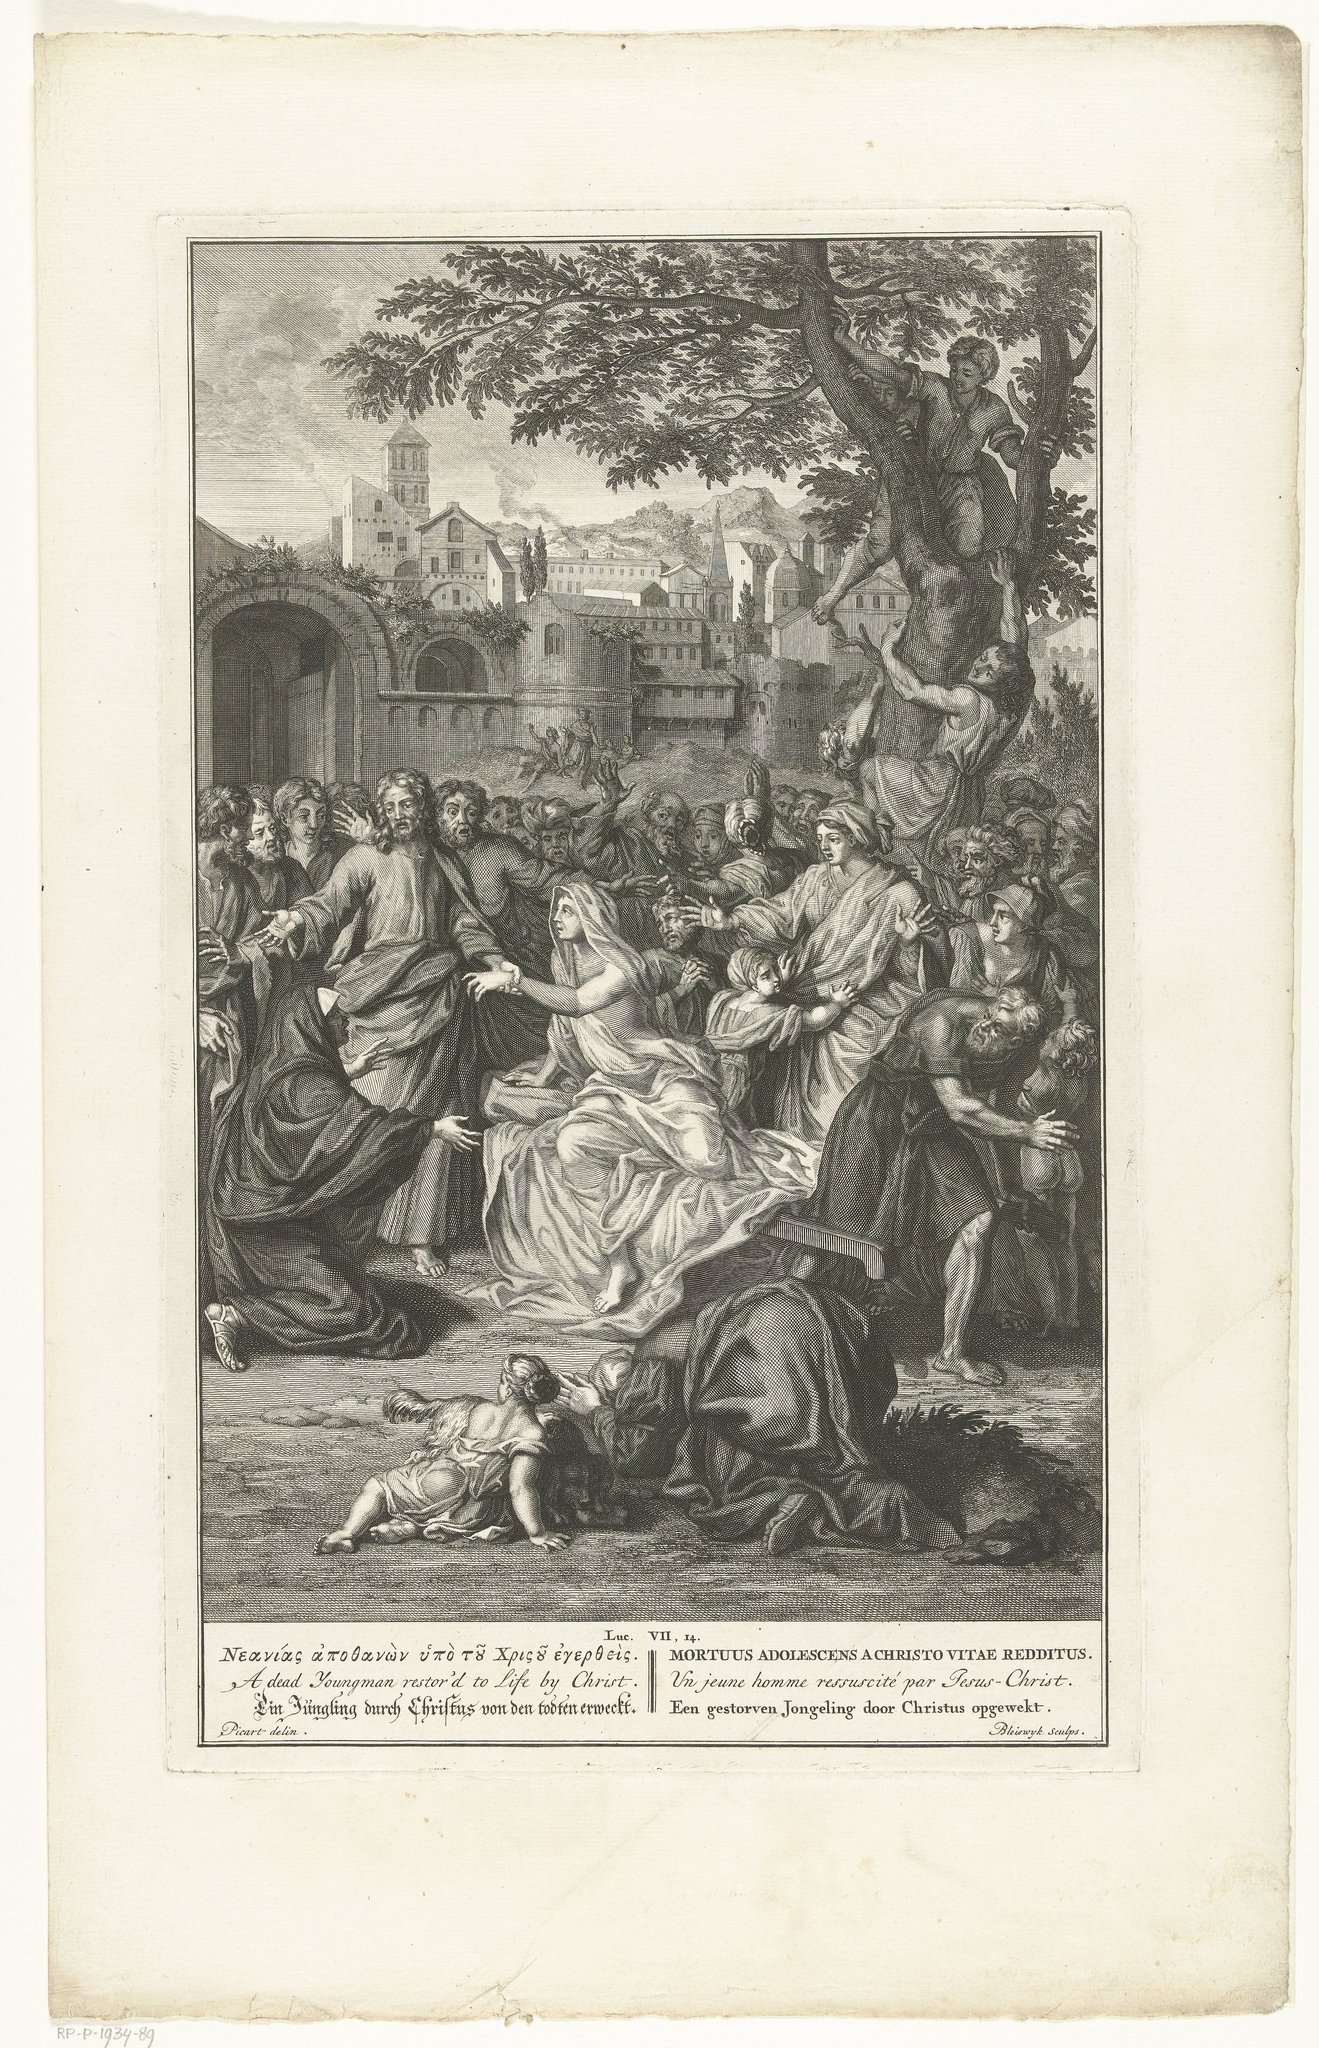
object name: book illustration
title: Opwekking van de zoon van de weduwe van Naïn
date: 1681-1728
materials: paper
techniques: engraving, etching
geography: leiden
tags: christ touches the bier of the son of the widow of nain: the young man sits up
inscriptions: collector's mark: Lugt 2228, inscription: ‘utrechts fundatie huijs’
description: Christus nadert stad Naïn met apostelen en menigte mensen en vlak bij stadspoort komt hij mannen tegen met dode lichaam van jongeman op een lijkbaar. Deze enige zoon van een weduwe wekt hij tot leven tot grote verbazing van de omstanders. Onder de voorstelling wordt in zes talen de bijbeltekst geciteerd uit Lucas 7:14